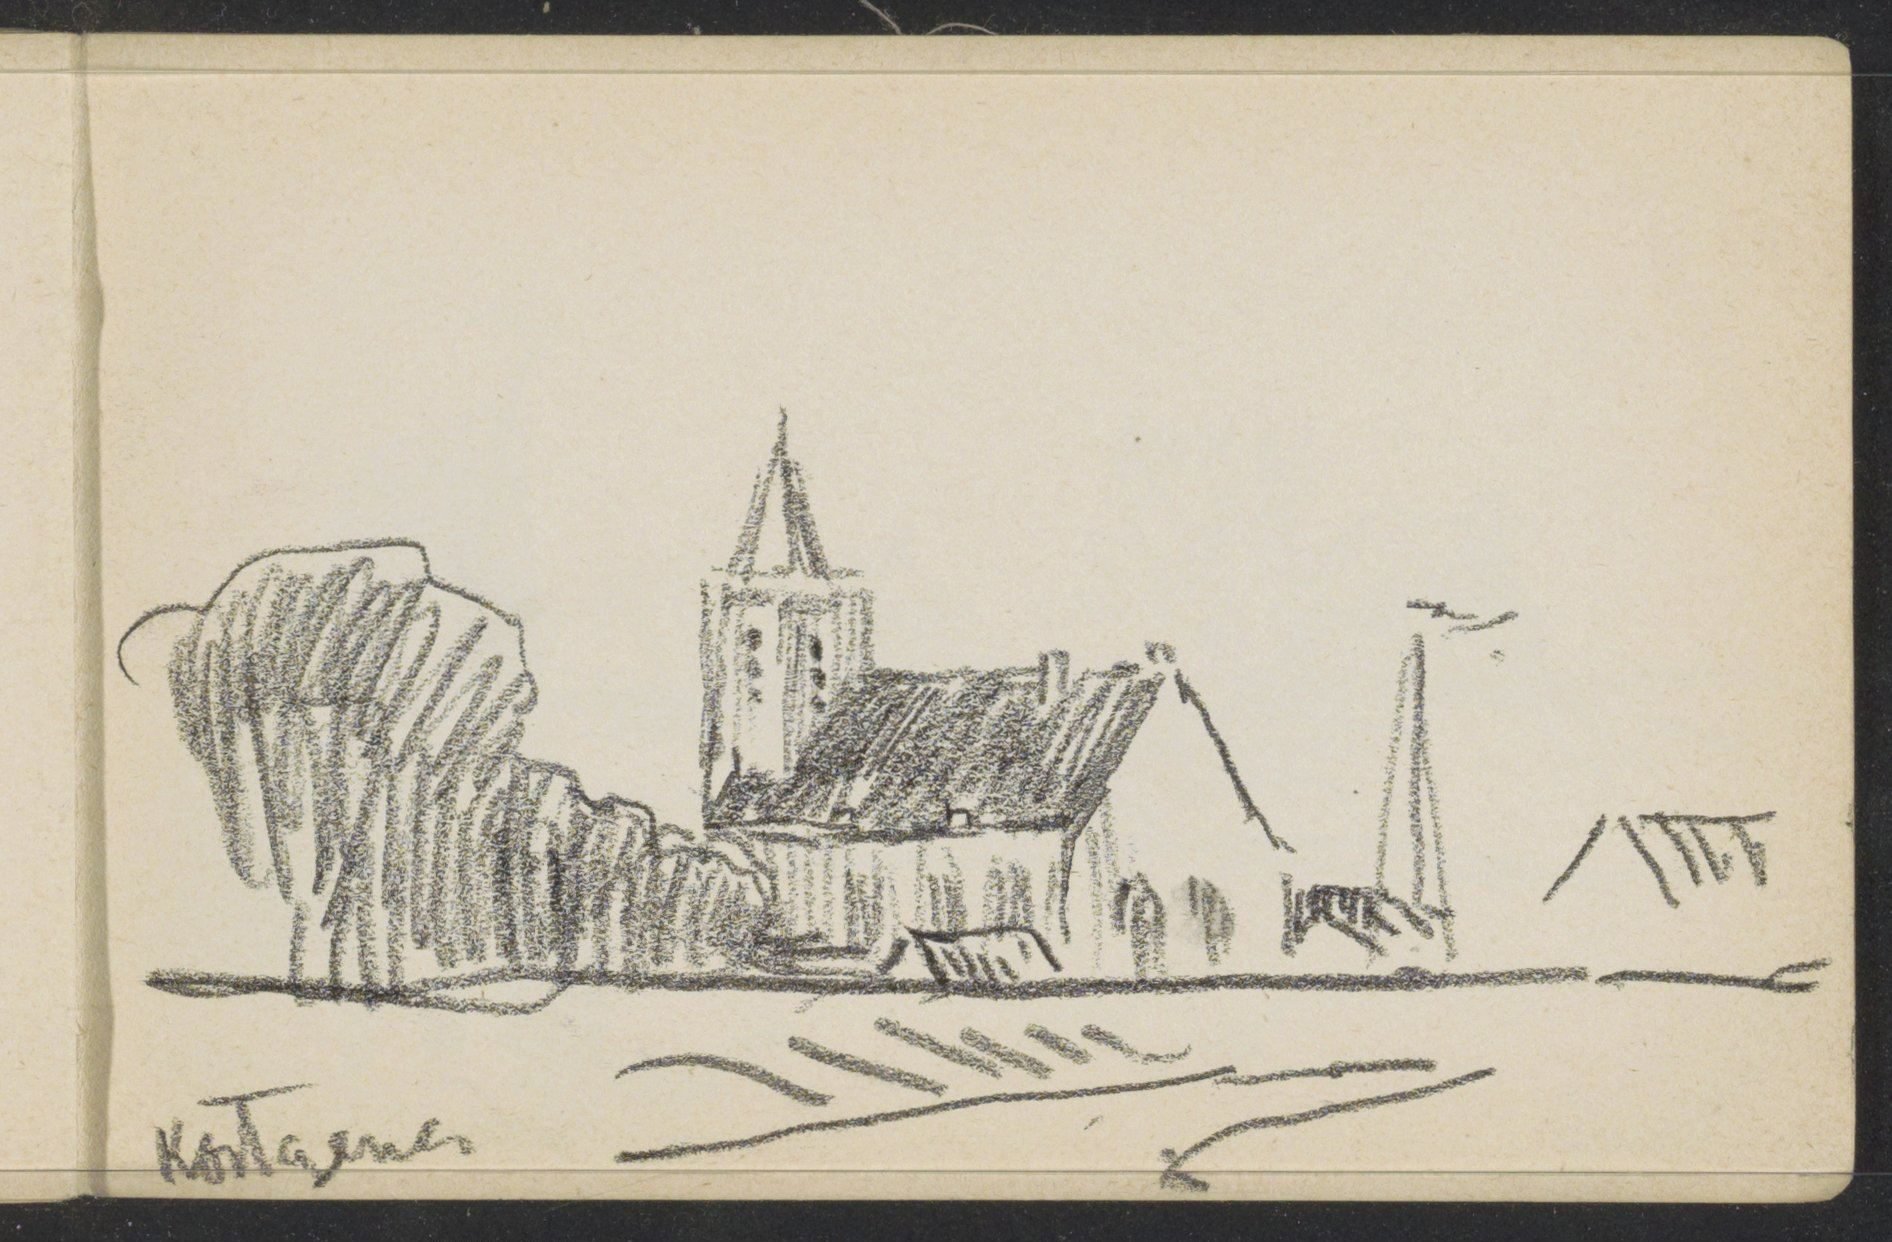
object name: sketchbook leaf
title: Nicolaaskerk te Kortgene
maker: alexander shilling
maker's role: draughtsman, print maker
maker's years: 1859-1937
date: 1910-1923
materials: chalk, paper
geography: kortgene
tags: church (exterior)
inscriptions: annotation: ‘kortgene’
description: Blad 25 recto uit een schetsboek met 26 bladen.